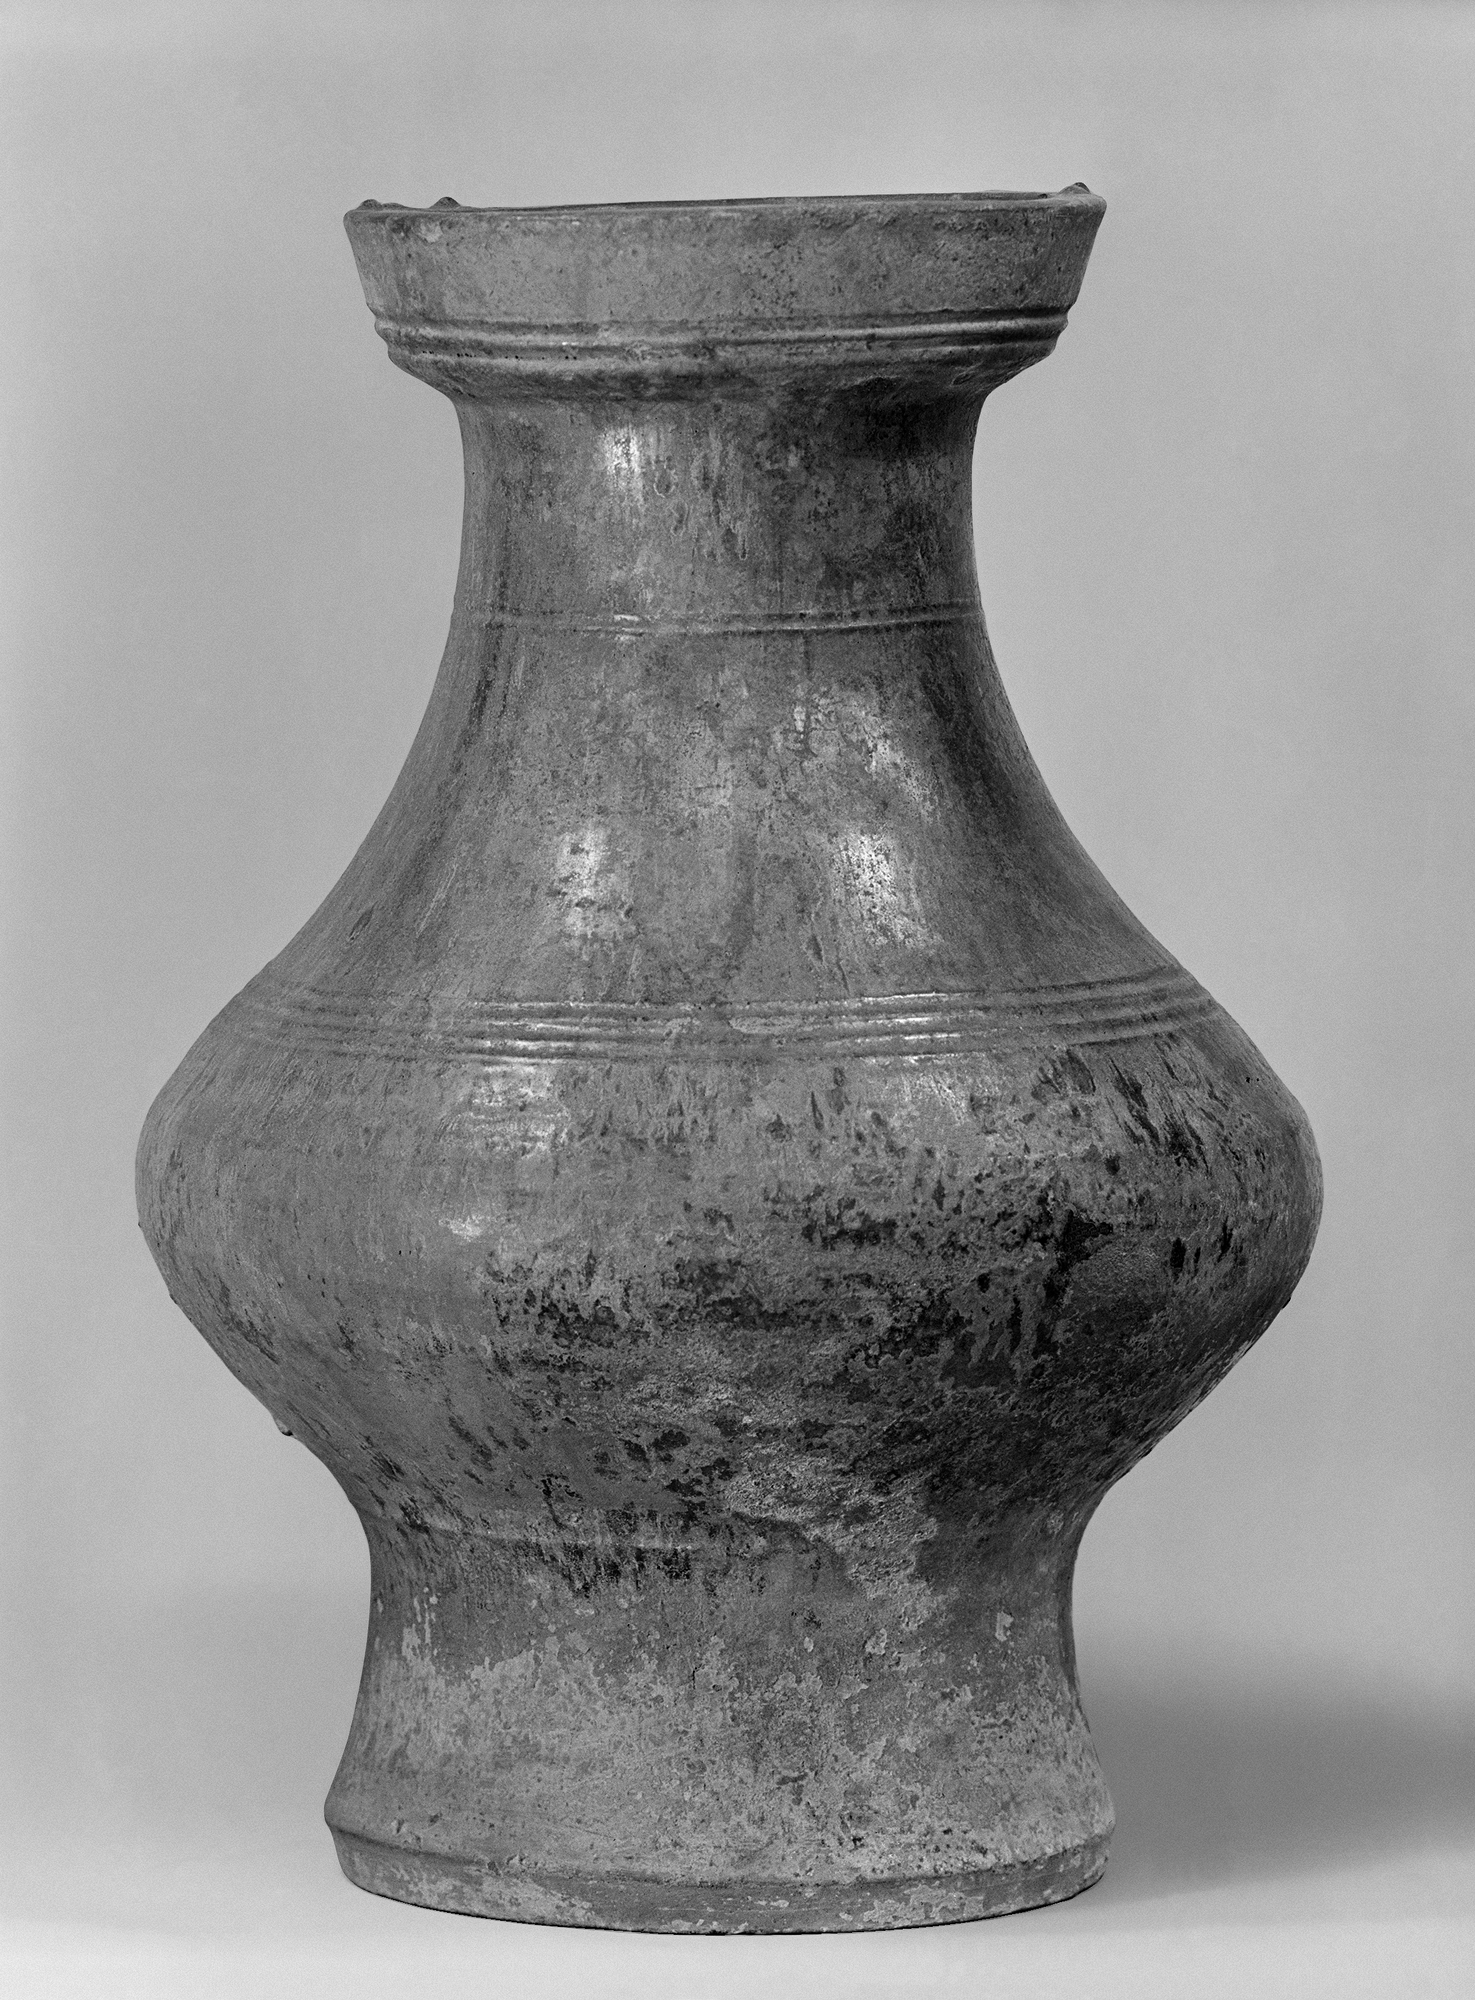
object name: vase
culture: chinese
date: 206 BCE-220 CE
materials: pottery